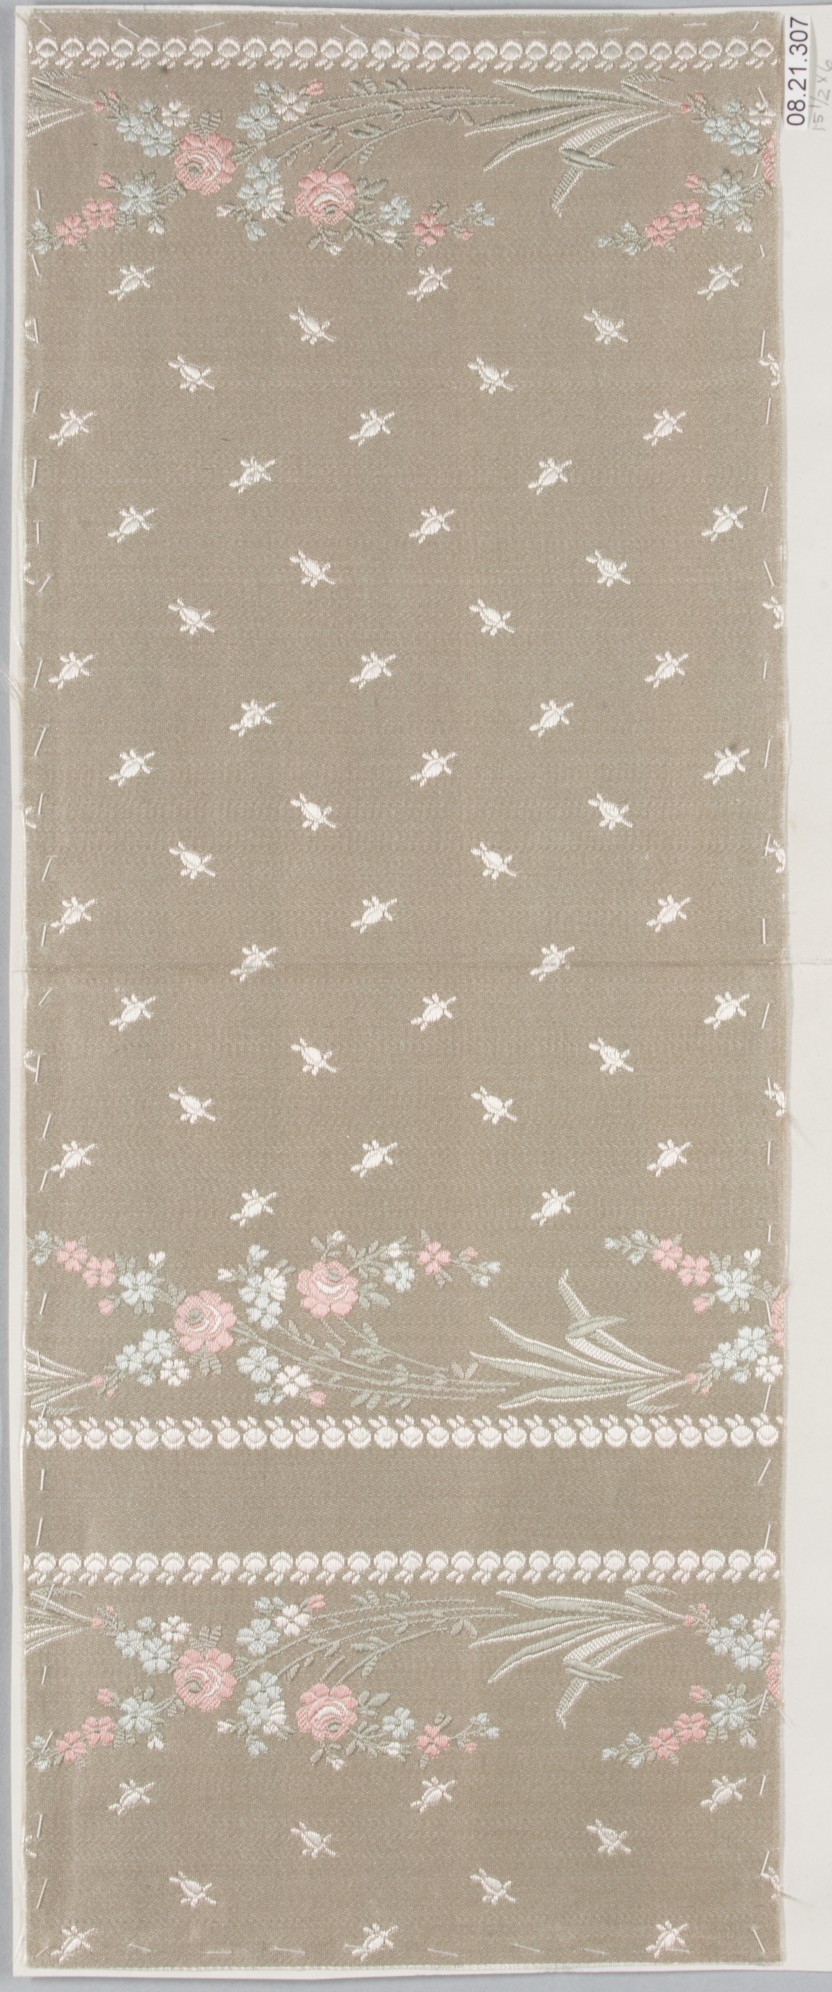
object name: textile sample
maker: Anonymous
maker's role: designer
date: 1900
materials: silk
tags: flowers